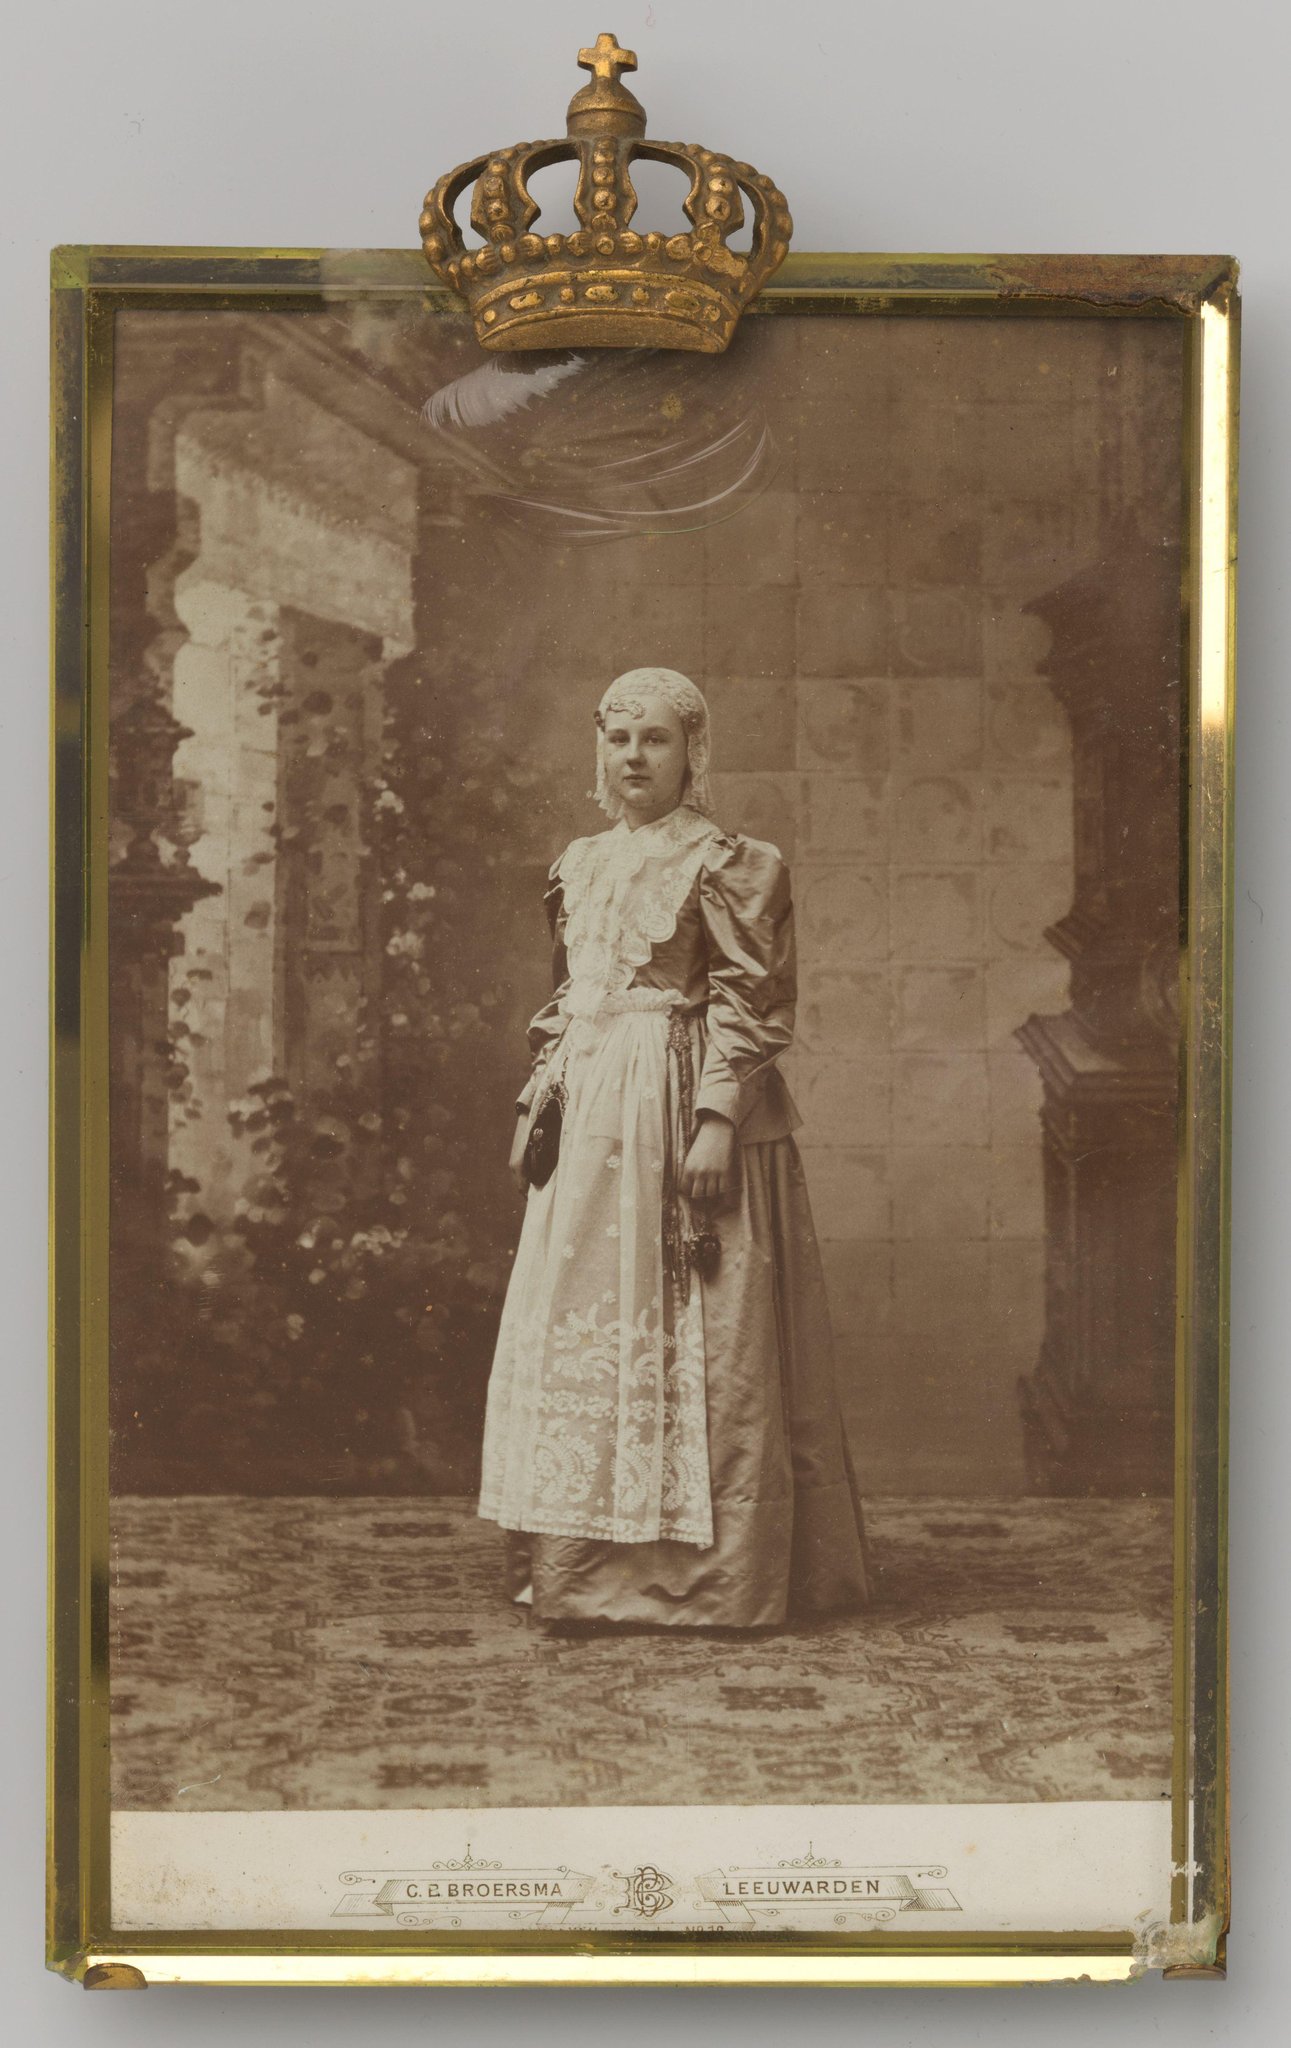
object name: frame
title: Portret van koningin Wilhelmina in Friese klederdracht, in keukendecor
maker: cornelis bernardus broersma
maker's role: fotograaf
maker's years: 1841-1919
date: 1892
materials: paper, cardboard, glass, metal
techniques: collodion silver print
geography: leeuwarden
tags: the hague, wilhelmina of the netherlands, historical persons, girl (child between toddler and youth), folk costume, regional costume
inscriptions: check stamp: ‘C.B.B./ Gedeponeerd’